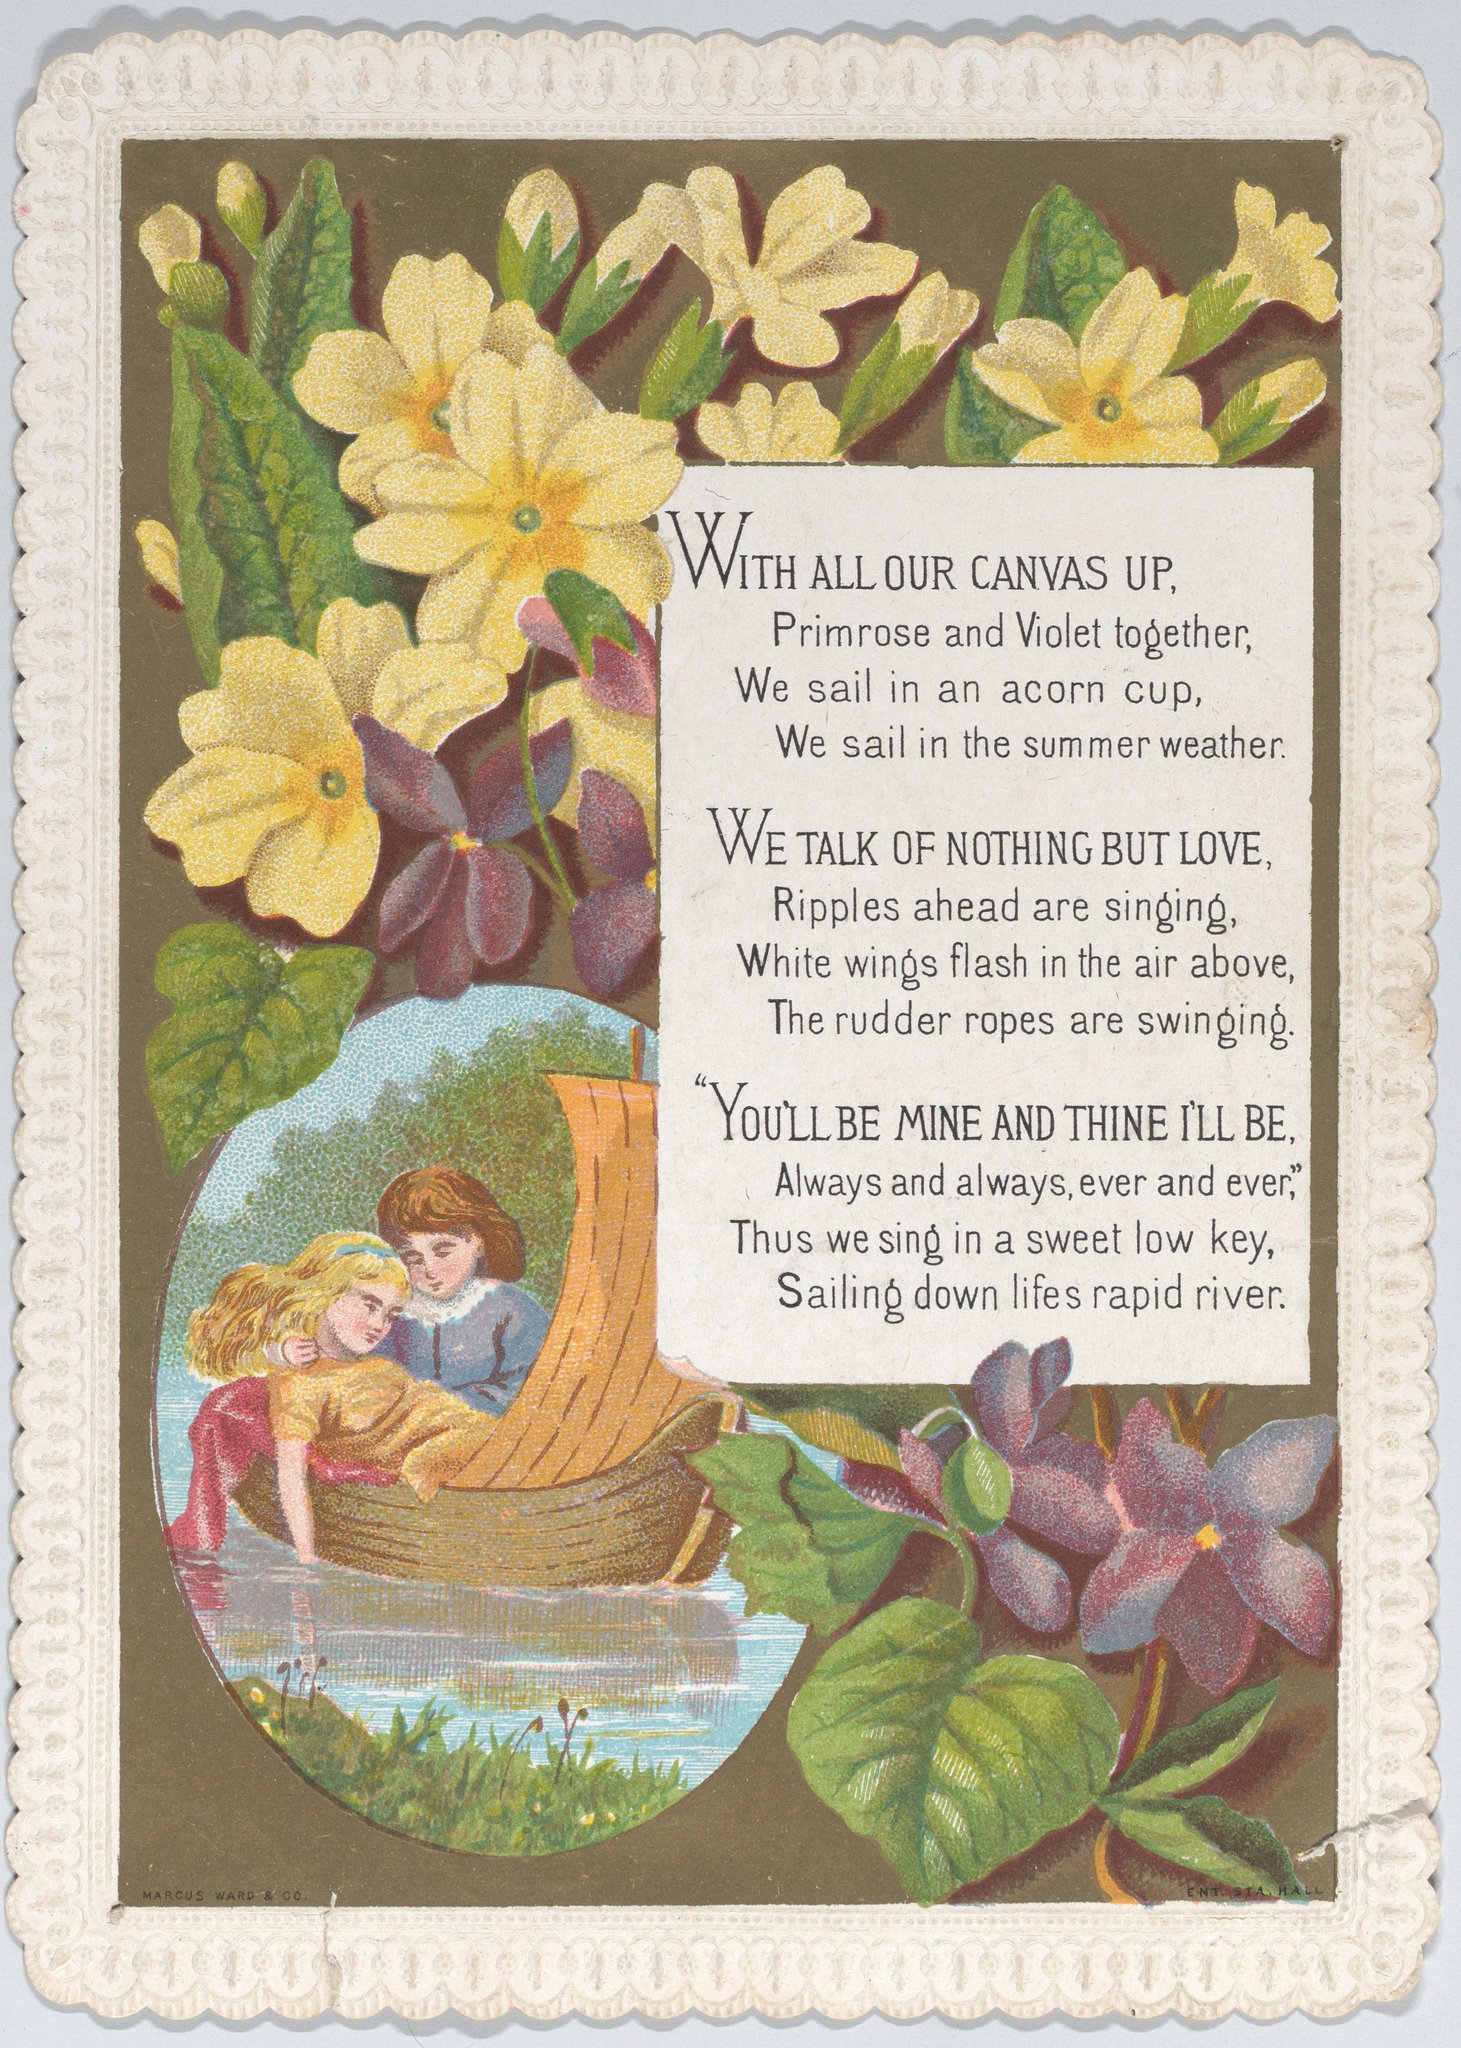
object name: valentine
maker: kate greenaway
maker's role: artist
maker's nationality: british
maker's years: 1846-1901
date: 1874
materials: gilt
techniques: chromolithography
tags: poetry,couples,flowers,boats